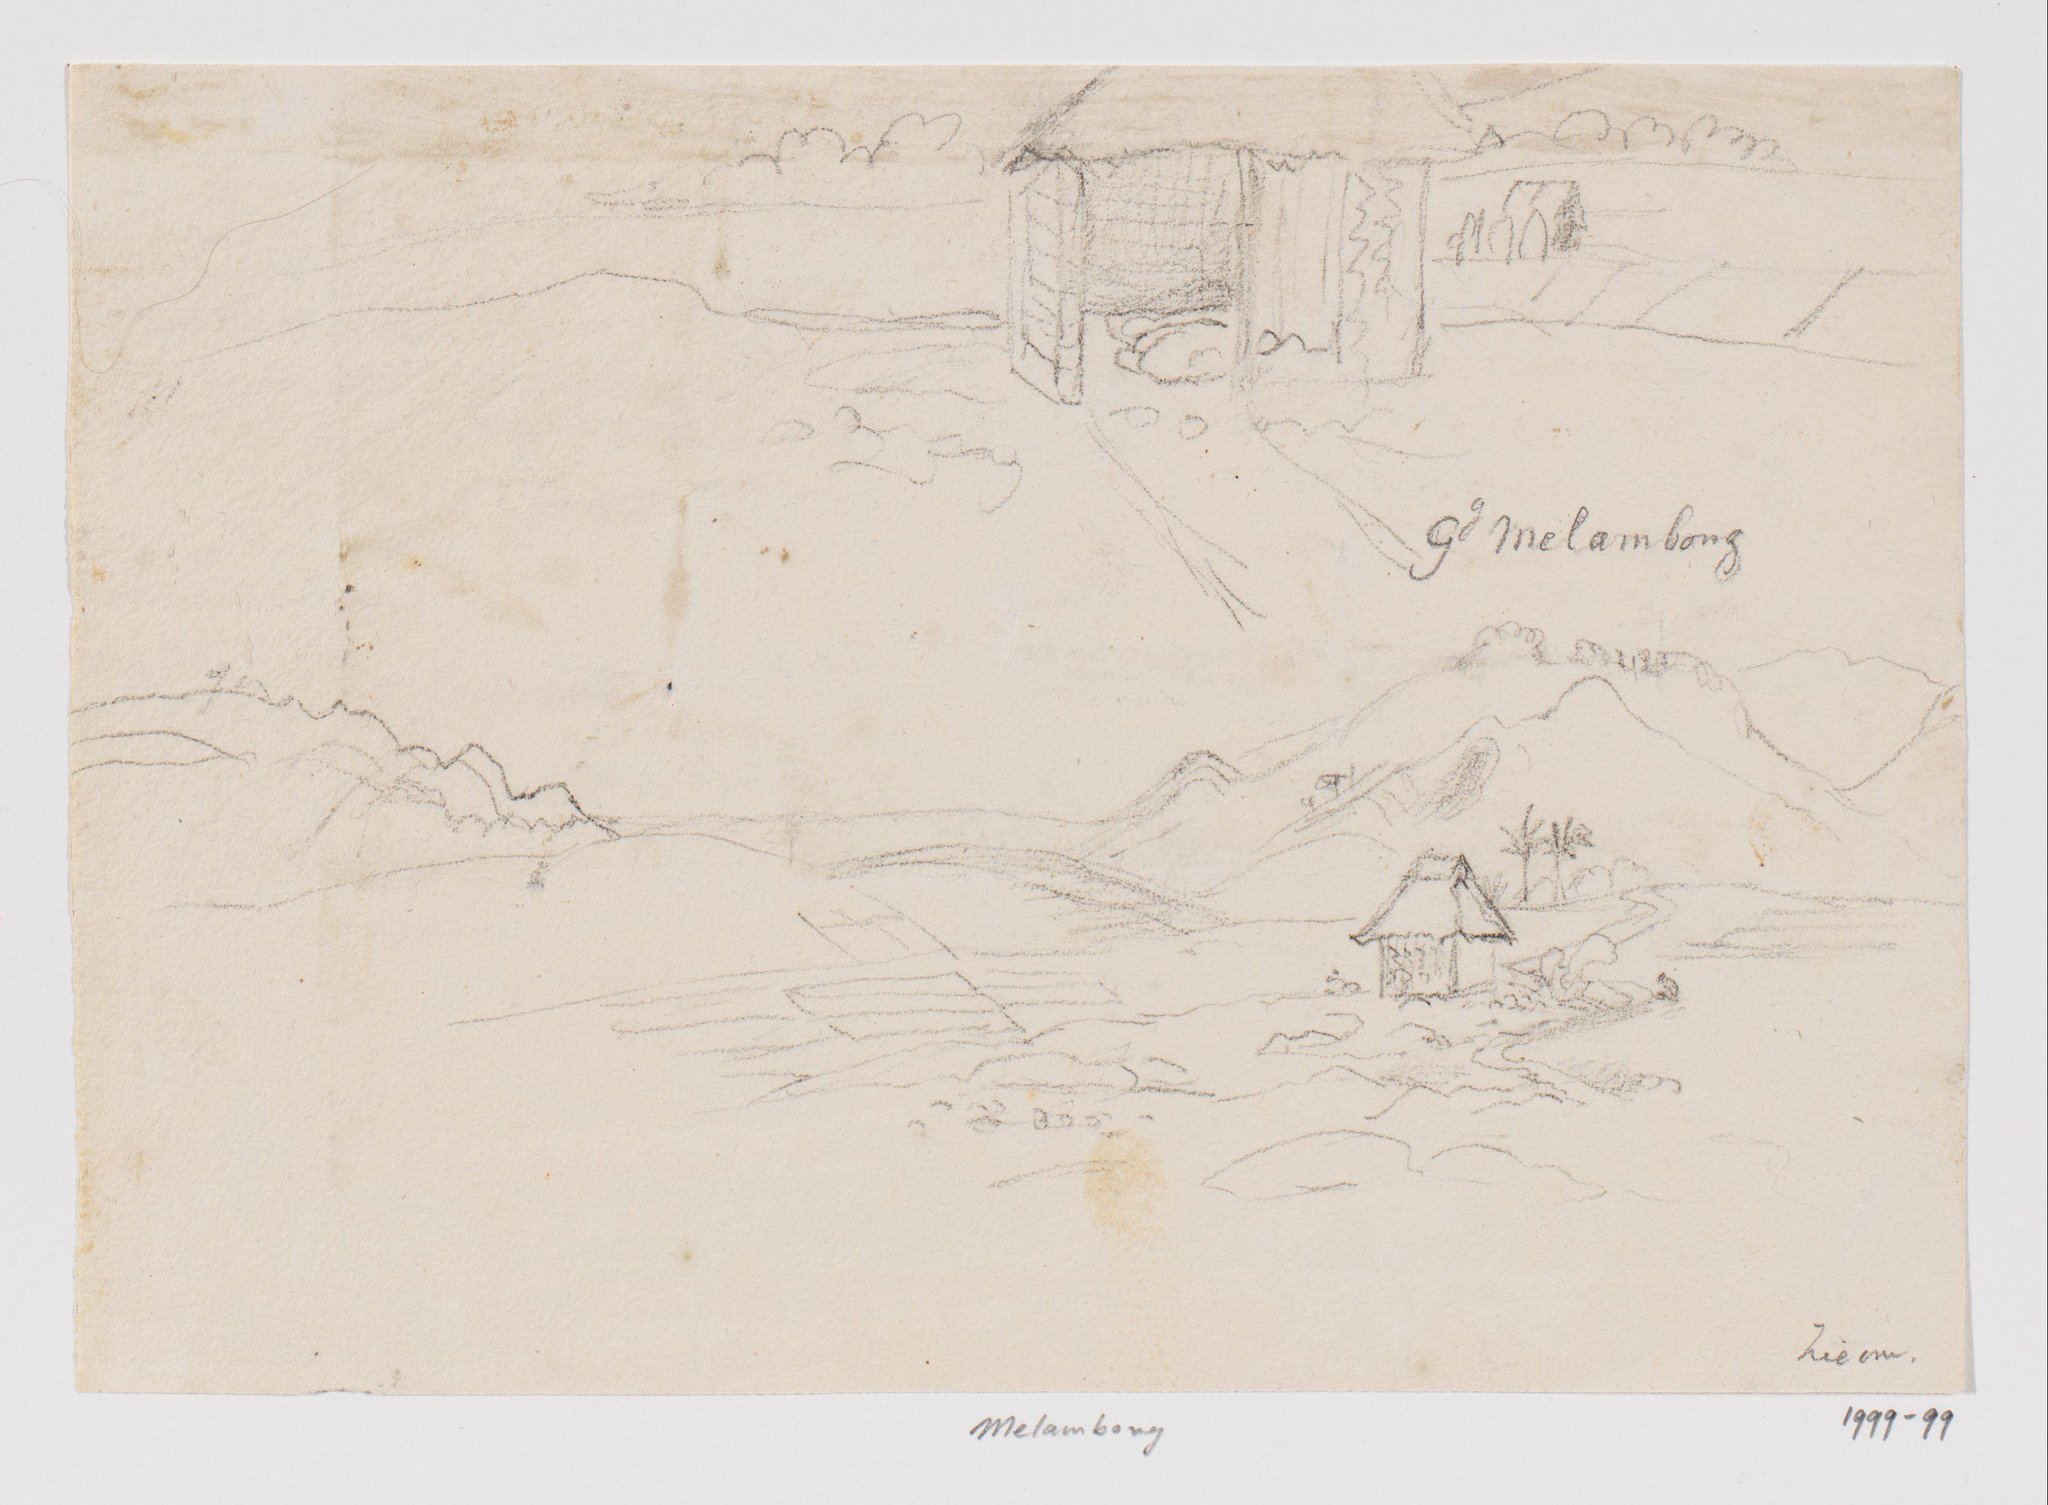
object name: drawing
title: Berglandschap op West-Java bij Malangbong, bovenaan een hut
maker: adrianus johannes bik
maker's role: draughtsman, print maker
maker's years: 1790-1872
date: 1816-1846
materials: chalk, paper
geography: west java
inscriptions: inscription: ‘g.Melambong’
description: Berglandschap op West-Java bij Malangbong; bovenaan een schets van een gedeeltelijk open hut met beddengoed op de vloer.